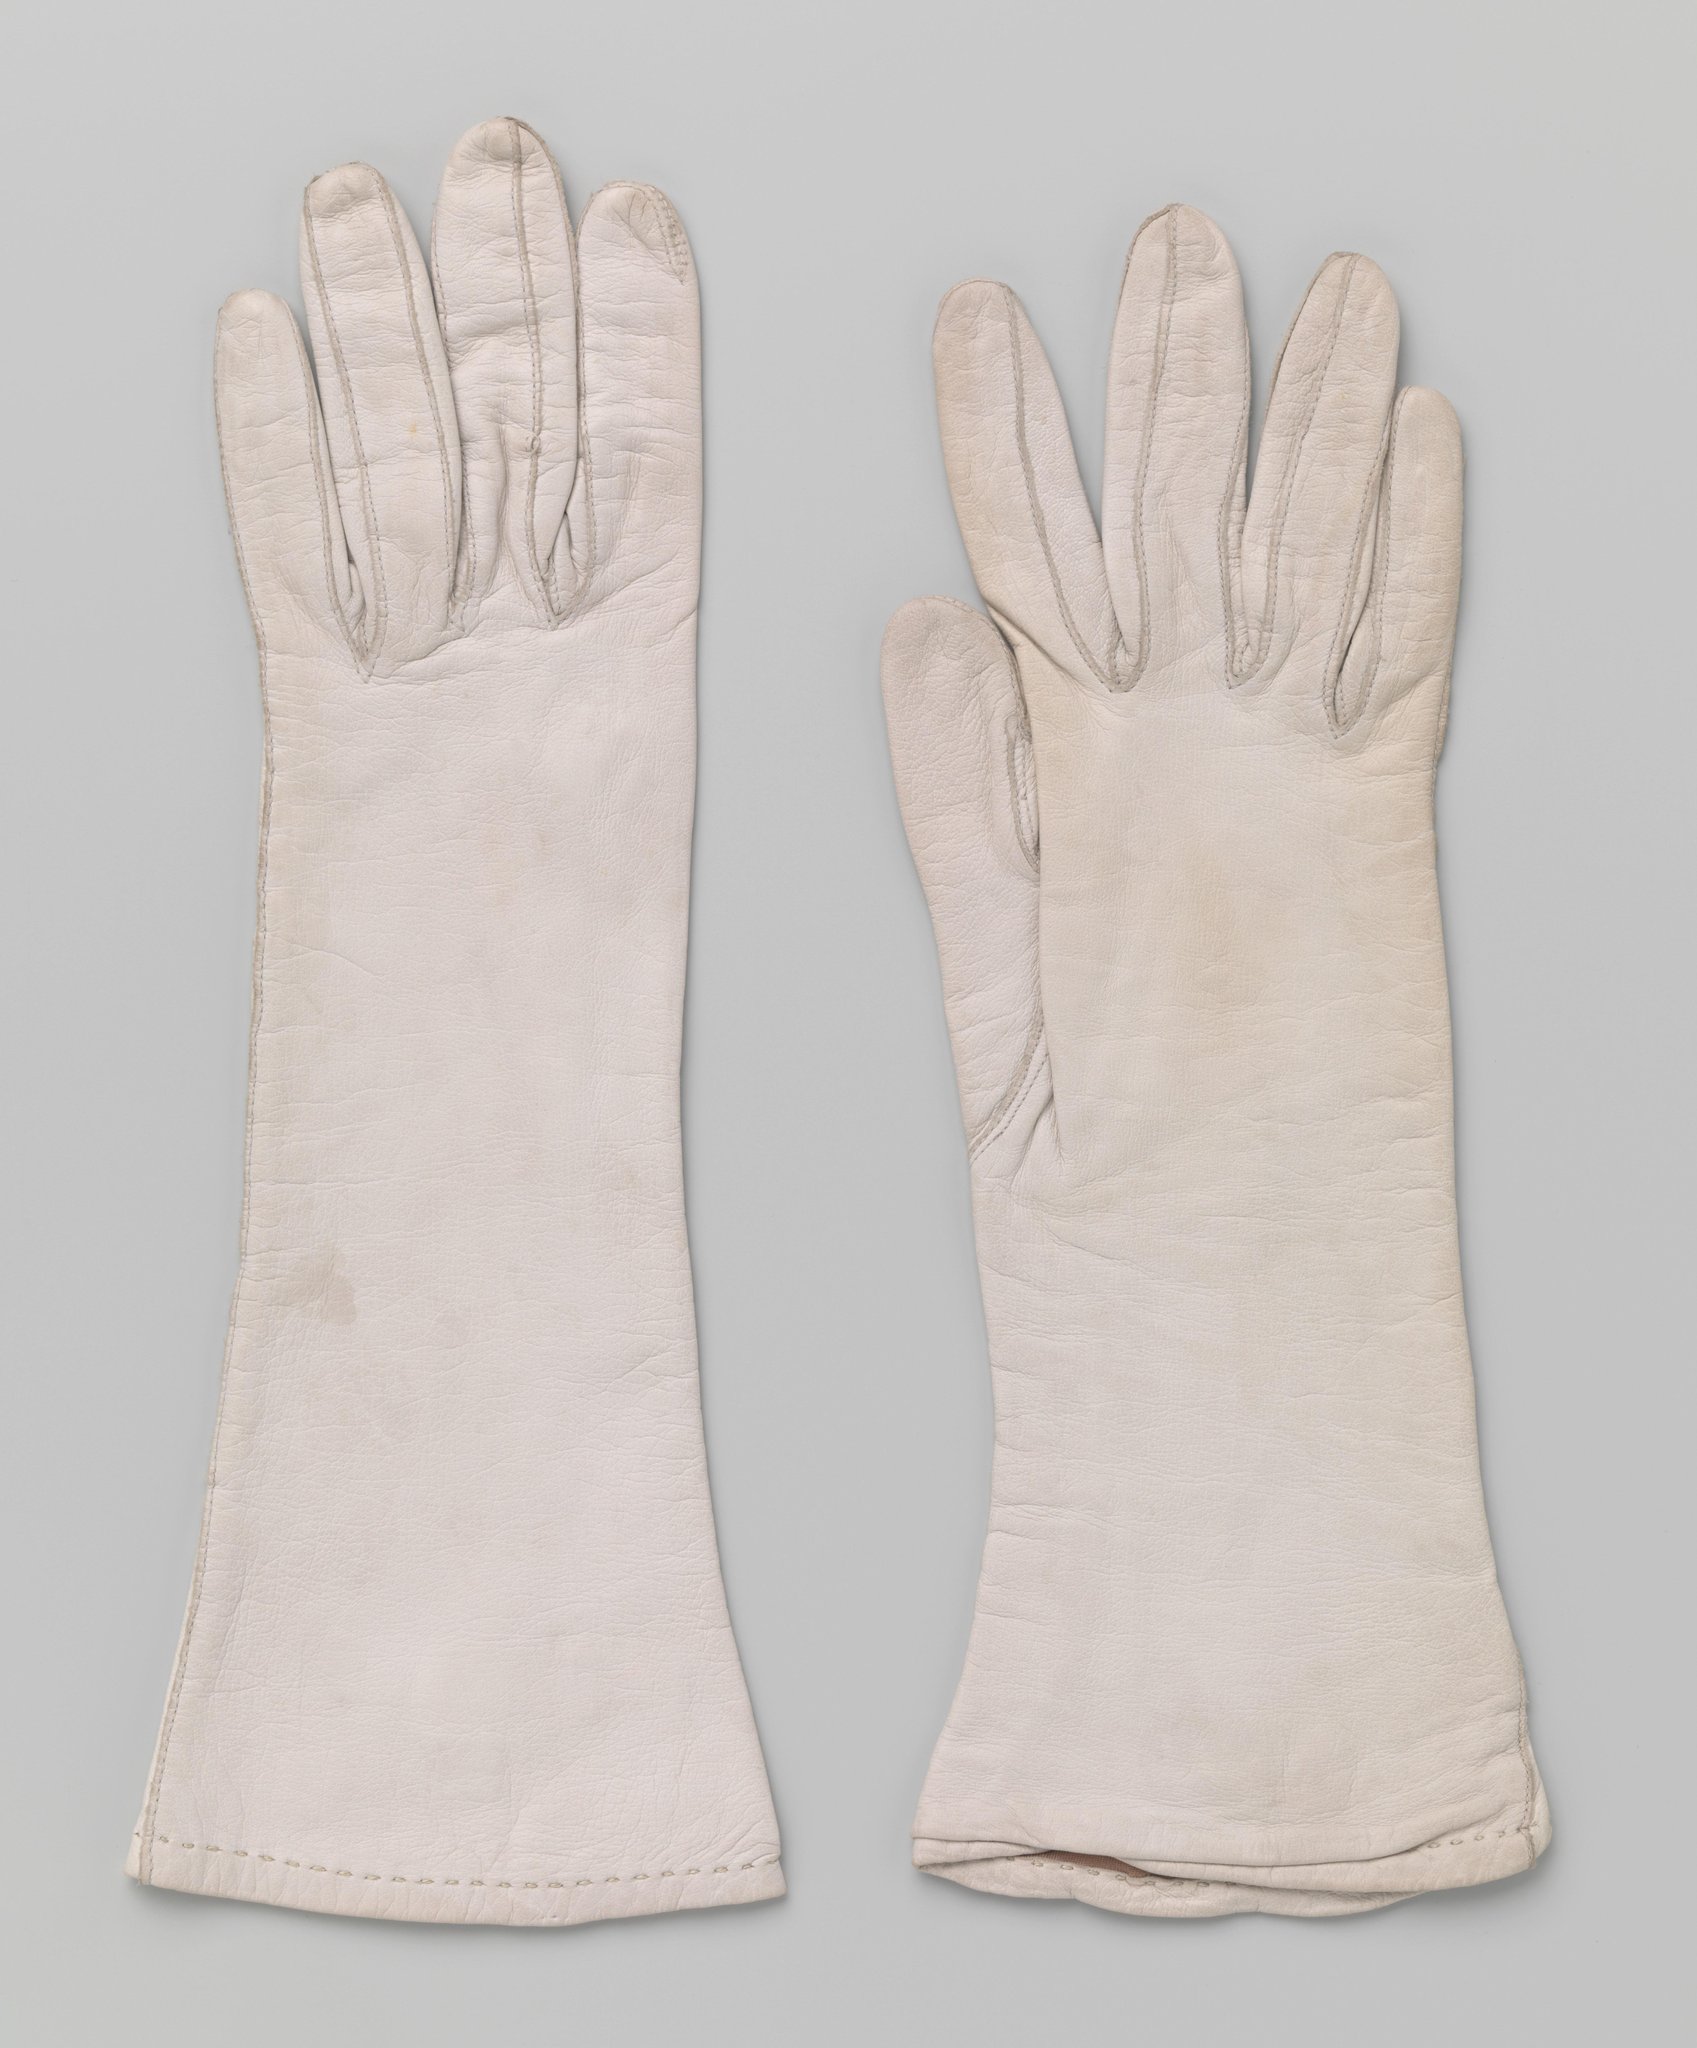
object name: glove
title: Handschoen van gevoerde grijze wasleer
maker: Anonymous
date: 1900-1915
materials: leather, textile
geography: western europe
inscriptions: label: ‘tekst’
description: Linker handschoen van gevoerde grijze wasleer.